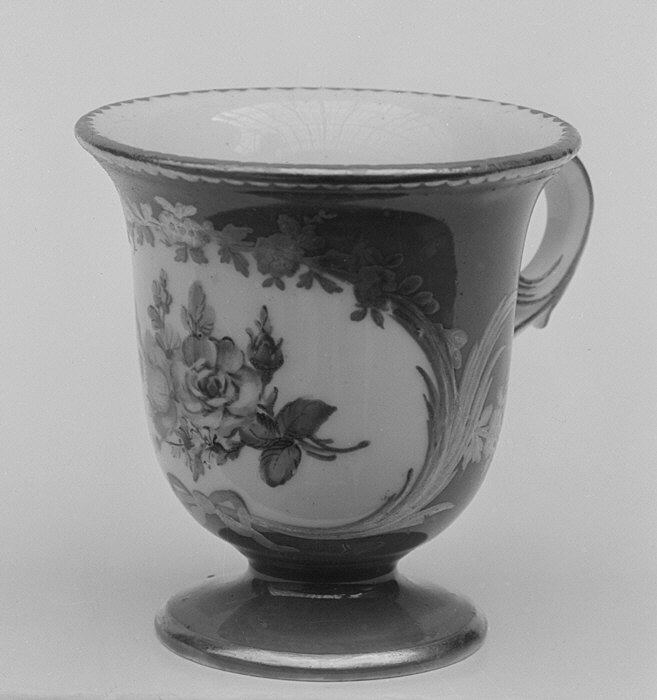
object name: ice cream cup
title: Ice cream cup (tasse à glace) (one of thirty-one) (part of a service)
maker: sèvres manufactory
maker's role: manufactory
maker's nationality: french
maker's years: 1740-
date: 1780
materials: soft paste porcelain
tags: flowers